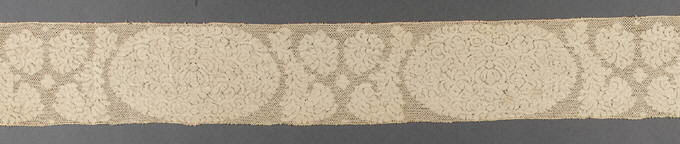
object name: border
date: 1701-1800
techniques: lace